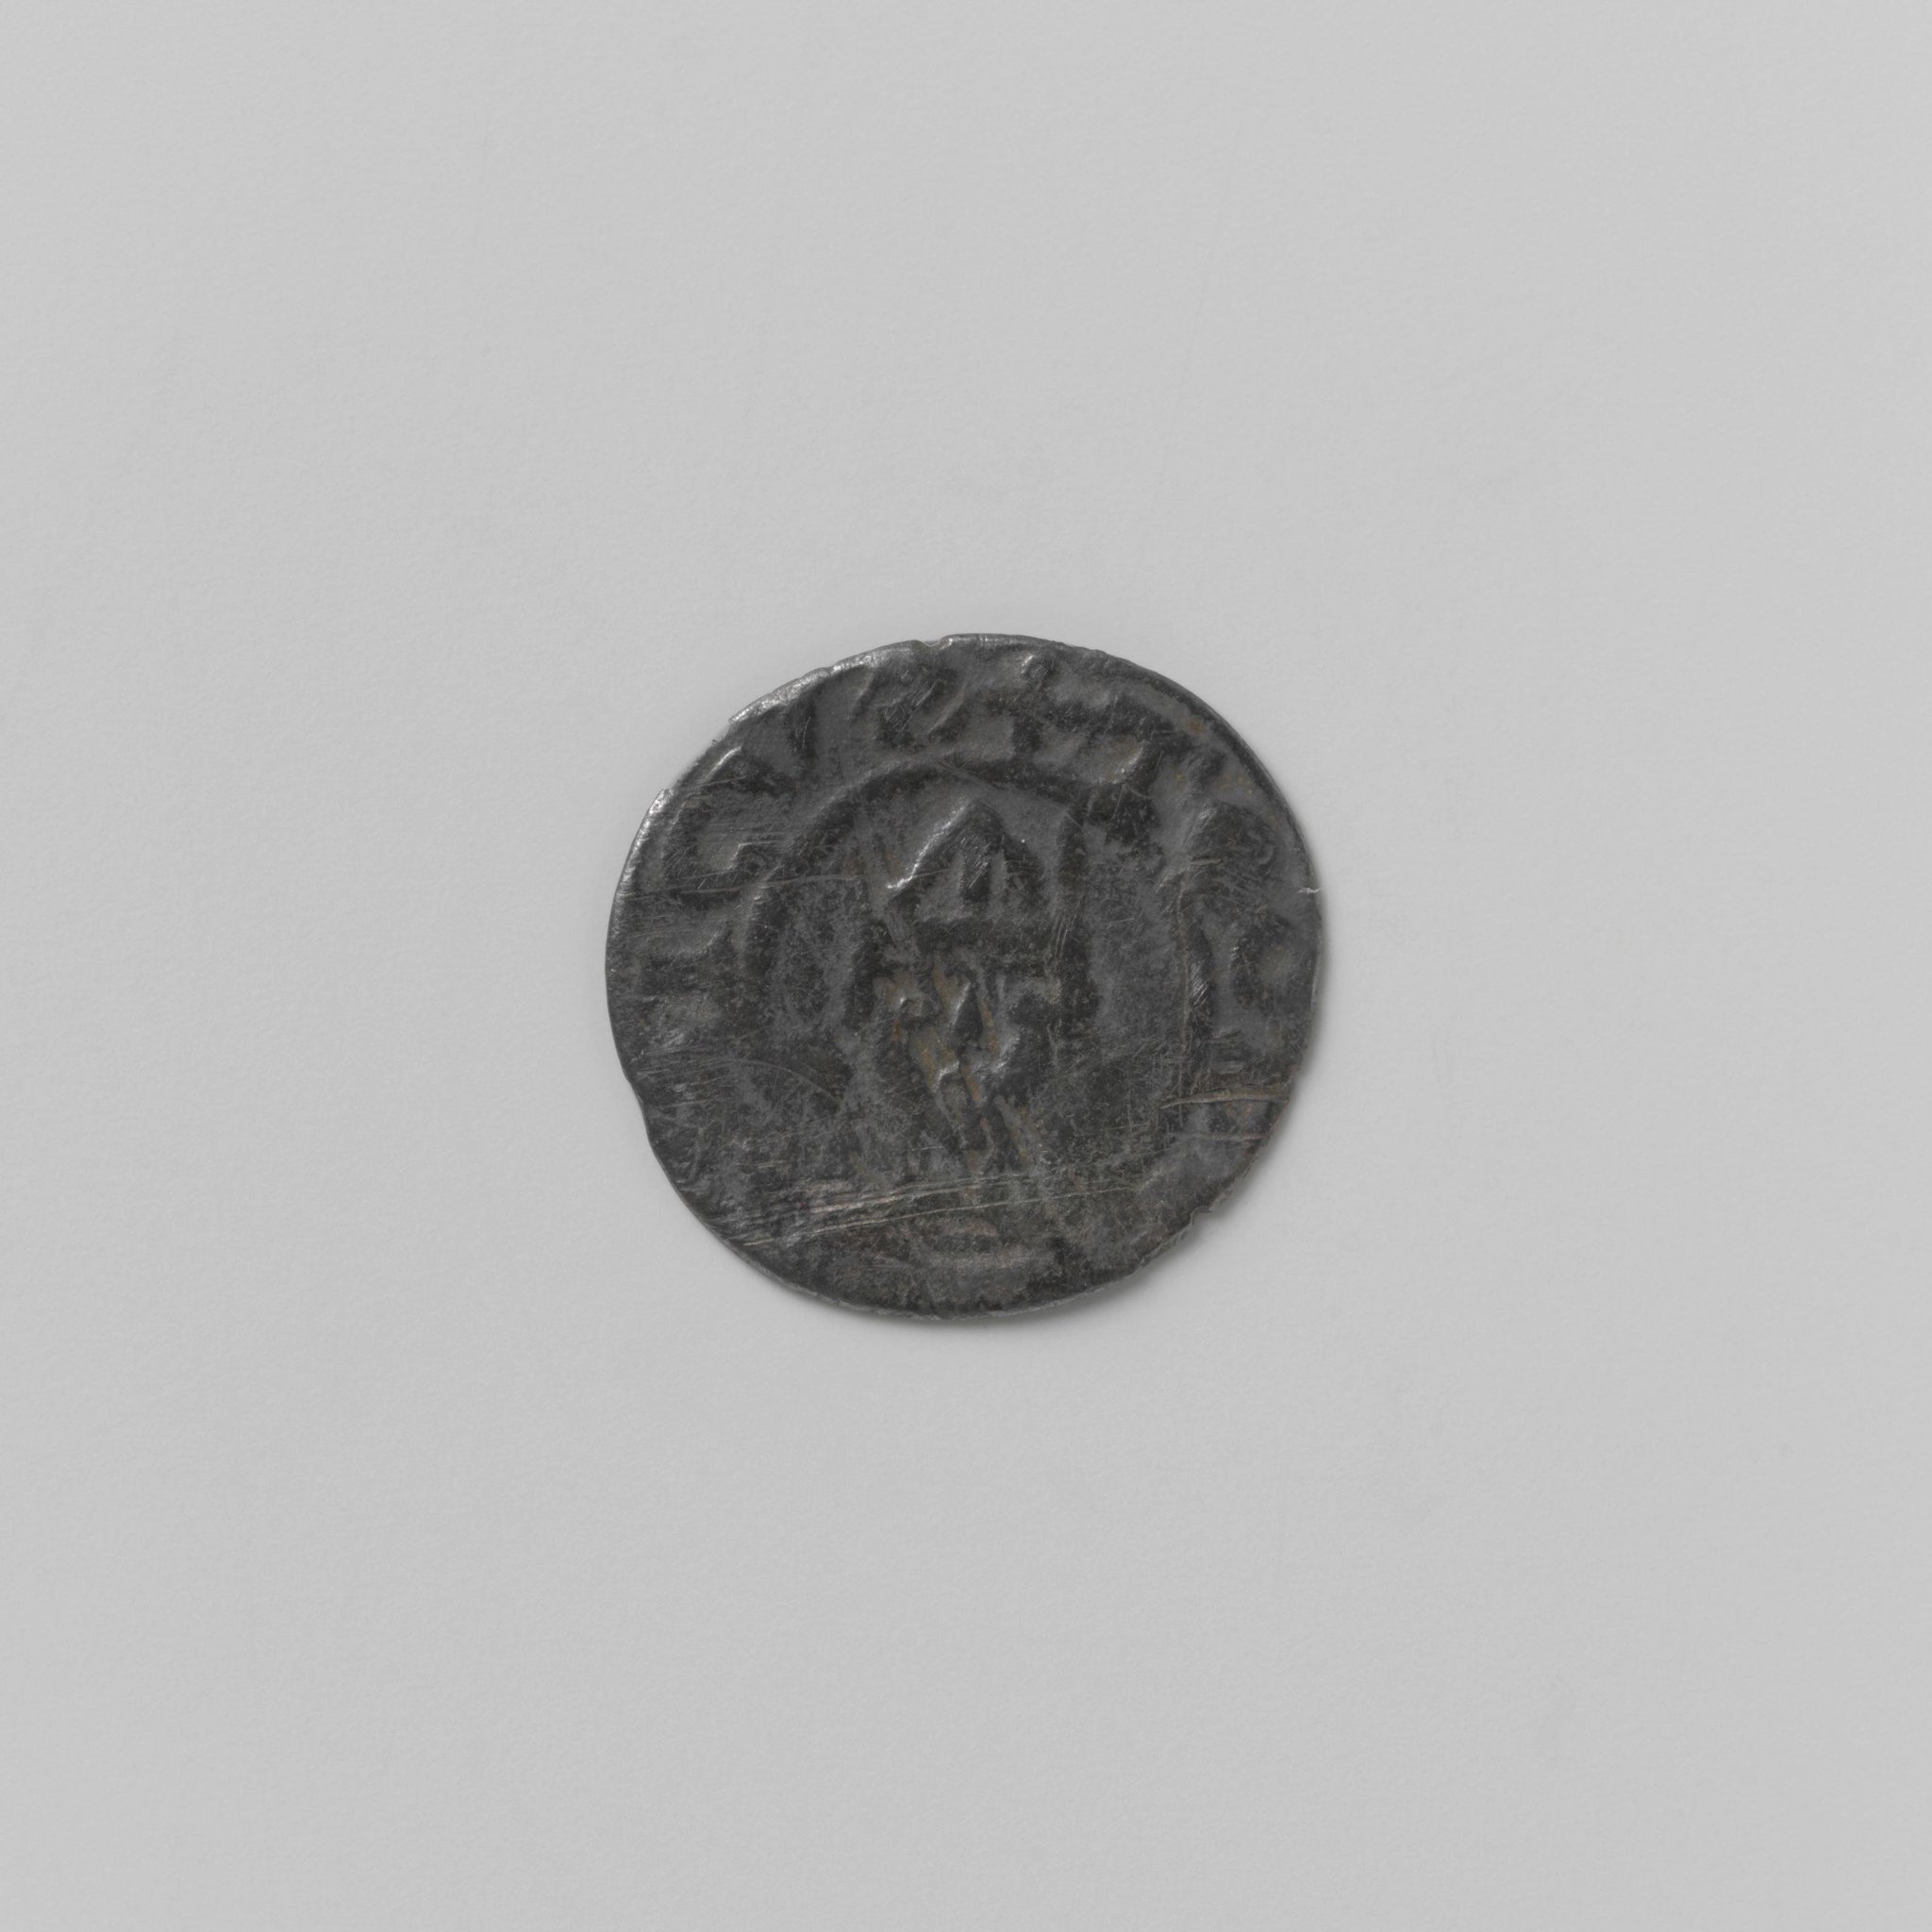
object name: coin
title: Utrechtse penning van Dirk van Ahr, 1198-1212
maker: dirk van are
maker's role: bisschop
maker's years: -1212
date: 1198-1212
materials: silver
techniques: striking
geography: utrecht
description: Zilveren munt. Voorzijde: portret van de bisschop van voren met mijter met in rechterhand bisschopsstaf. Omschrift. Keerzijde: kort kruis, in hoeken afwisselend sterretje en drietand. Omschrift.